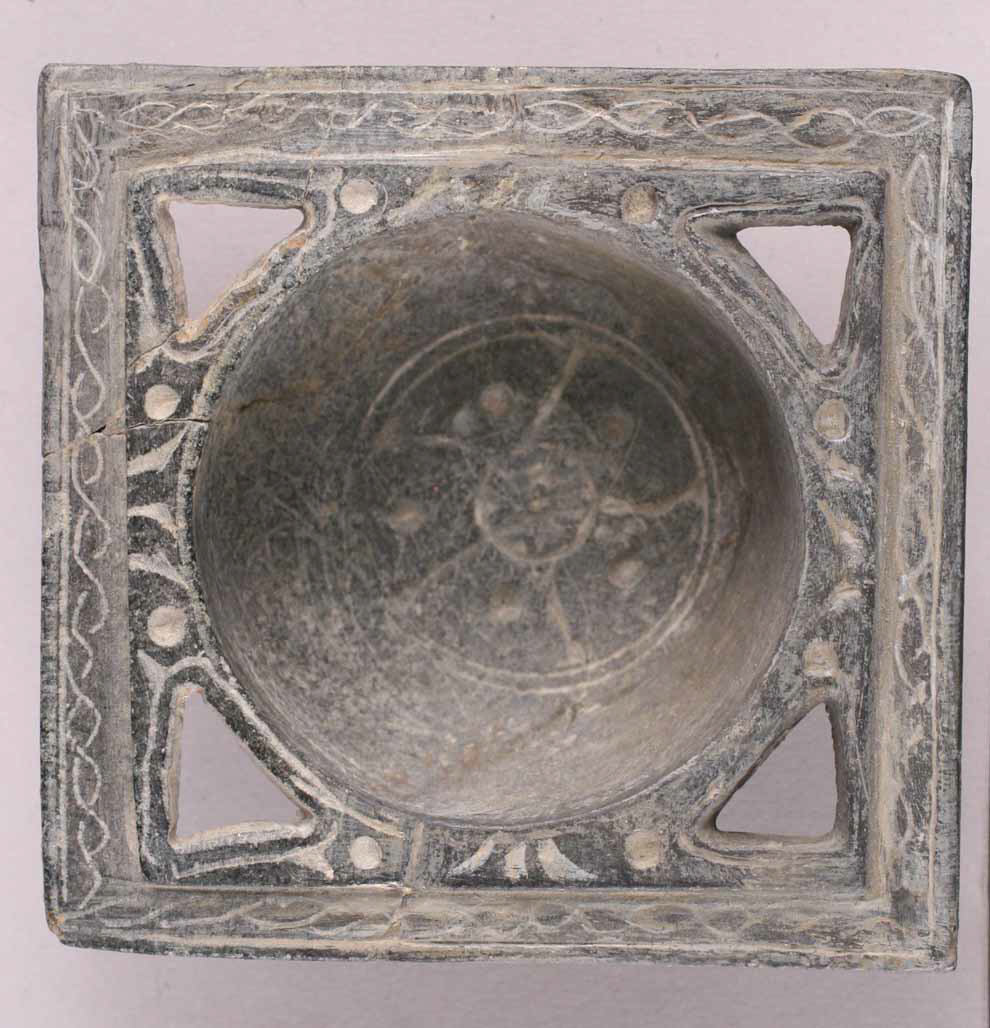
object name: dish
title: Stone Dish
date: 901-1100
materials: stone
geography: iran